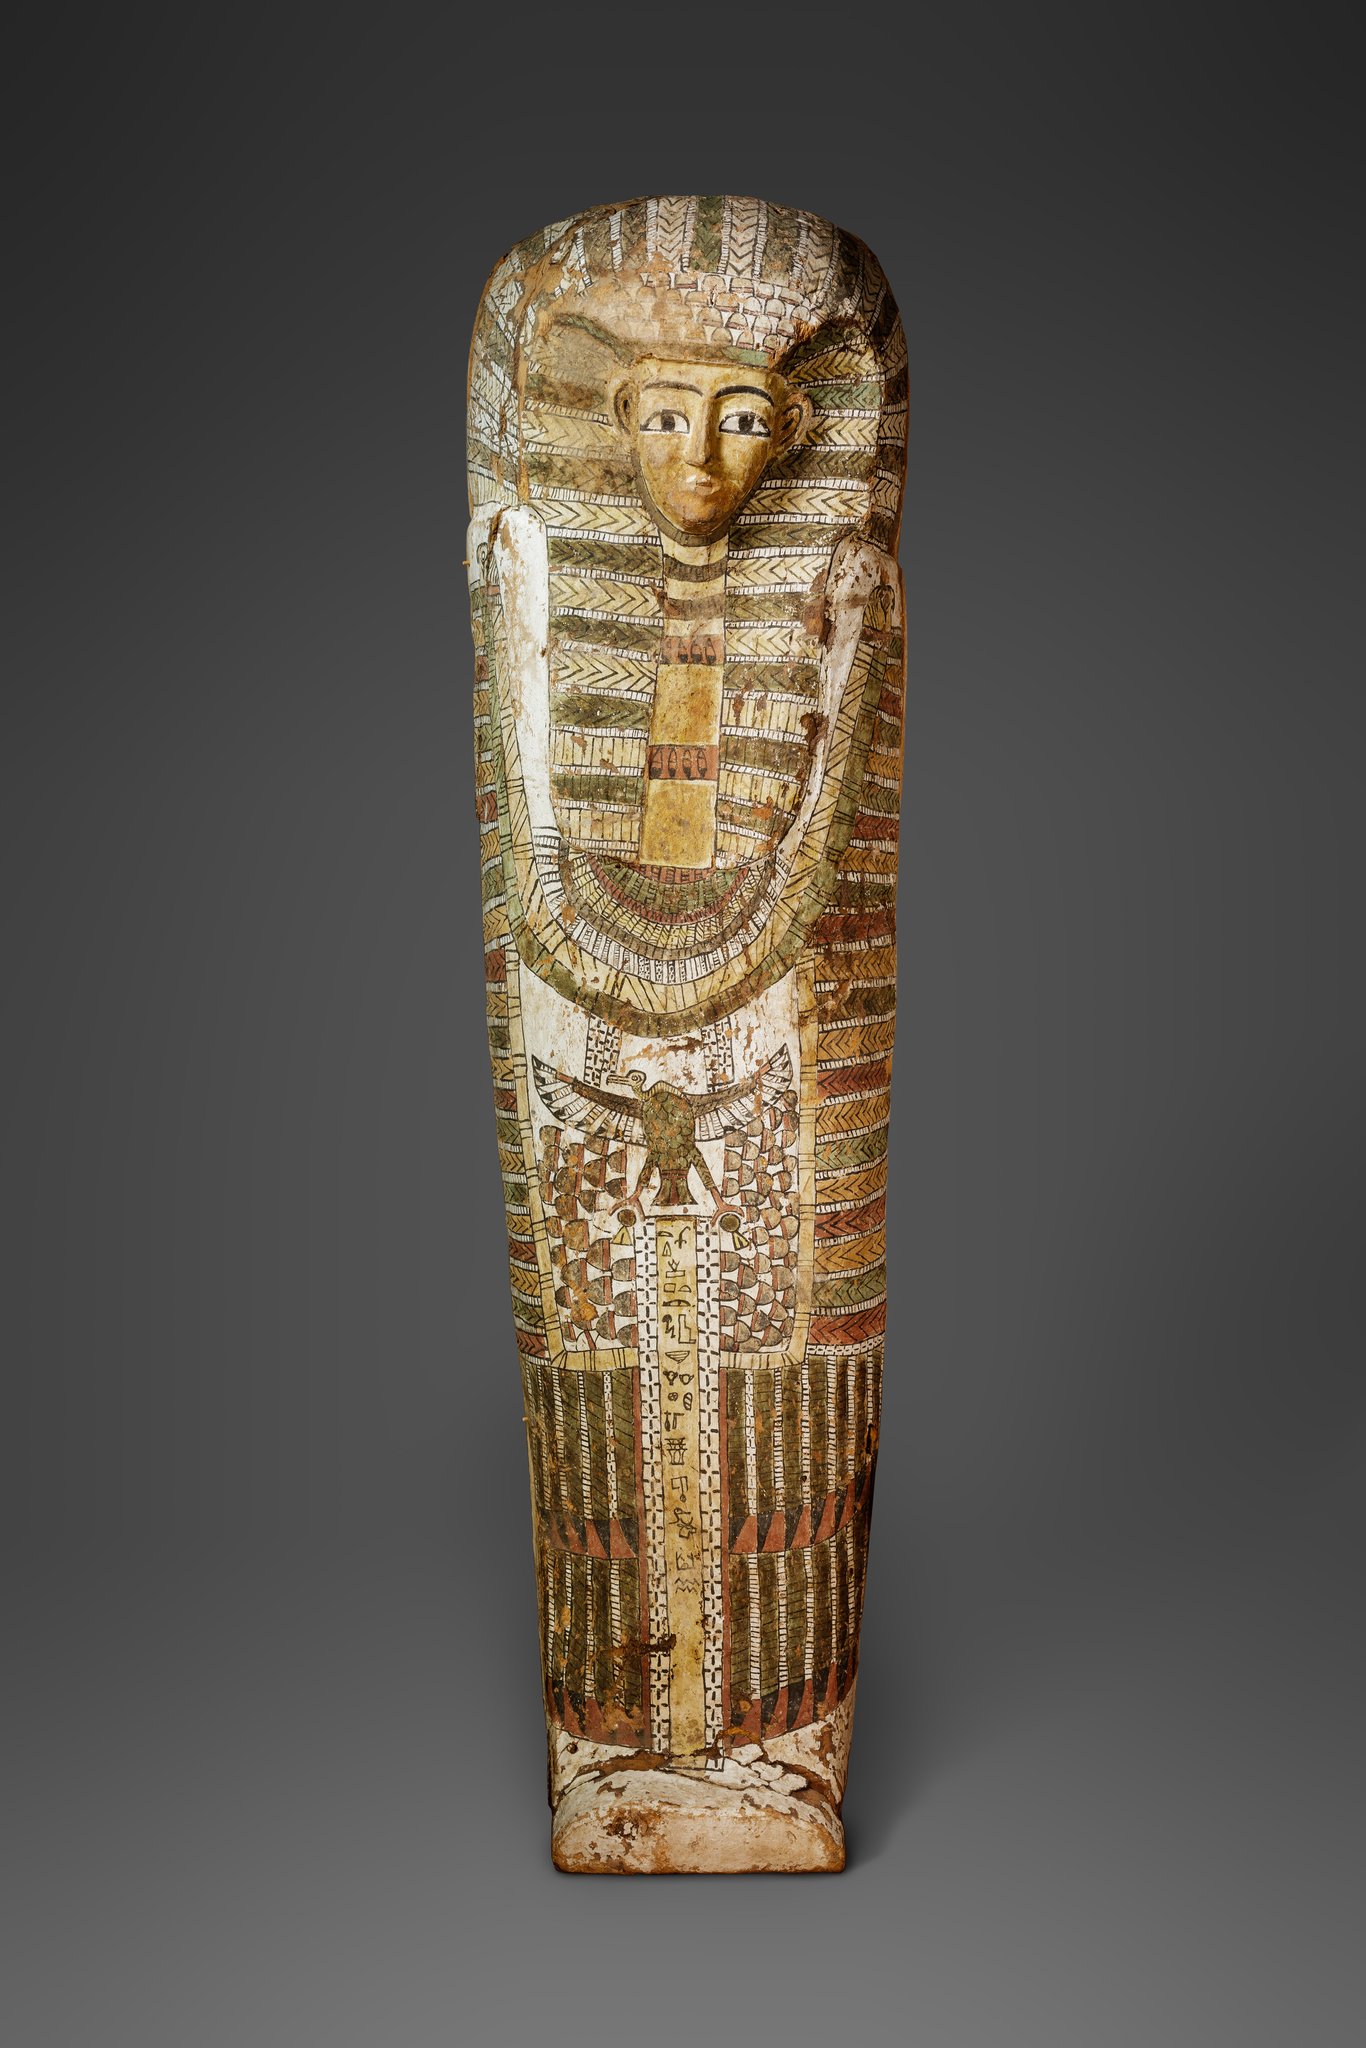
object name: coffin, rishi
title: Rishi coffin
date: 1580-1479 BCE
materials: paint, plaster, wood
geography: egypt